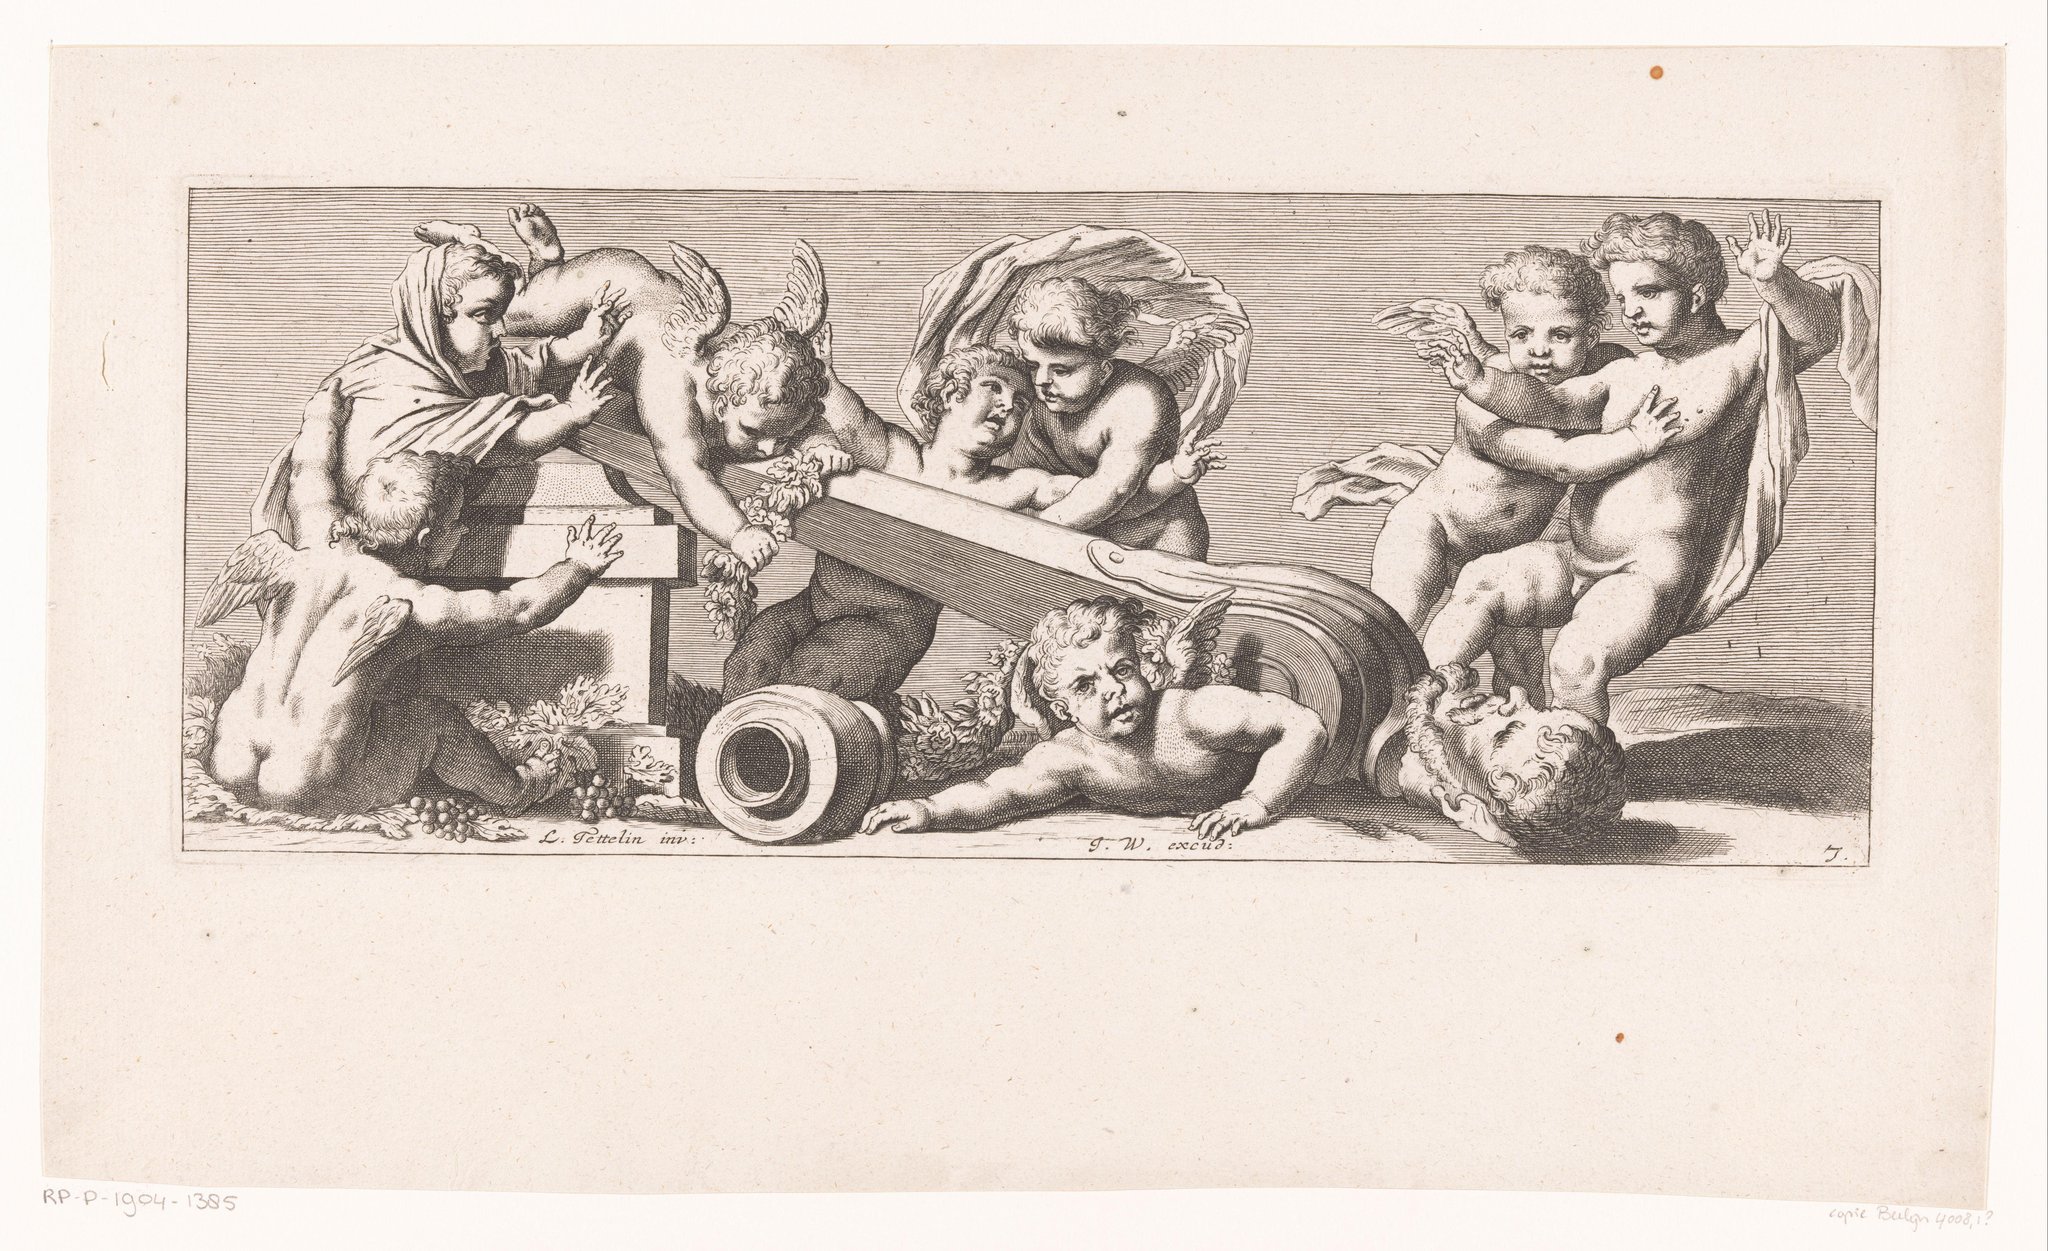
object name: print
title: Putti met omgevallen term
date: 1673-1724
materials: paper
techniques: etching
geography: germany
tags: pedestal of a piece of sculpture (perhaps in the form of a herm), cupids: 'amores', 'amoretti', 'putti'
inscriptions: collector's mark: Lugt 2228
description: Een fries met putti met een omgevallen term. Links liggen een omgevallen pot of vaas en wijnranken.